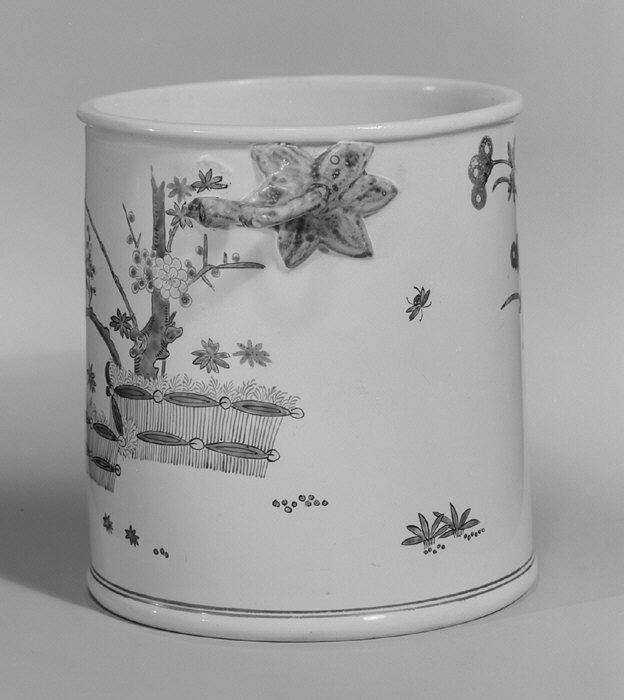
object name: wine cooler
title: Wine bottle cooler (one of a pair)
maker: chantilly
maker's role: factory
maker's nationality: french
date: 1730-1735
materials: silver, soft paste porcelain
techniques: glazing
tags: flowers,trees